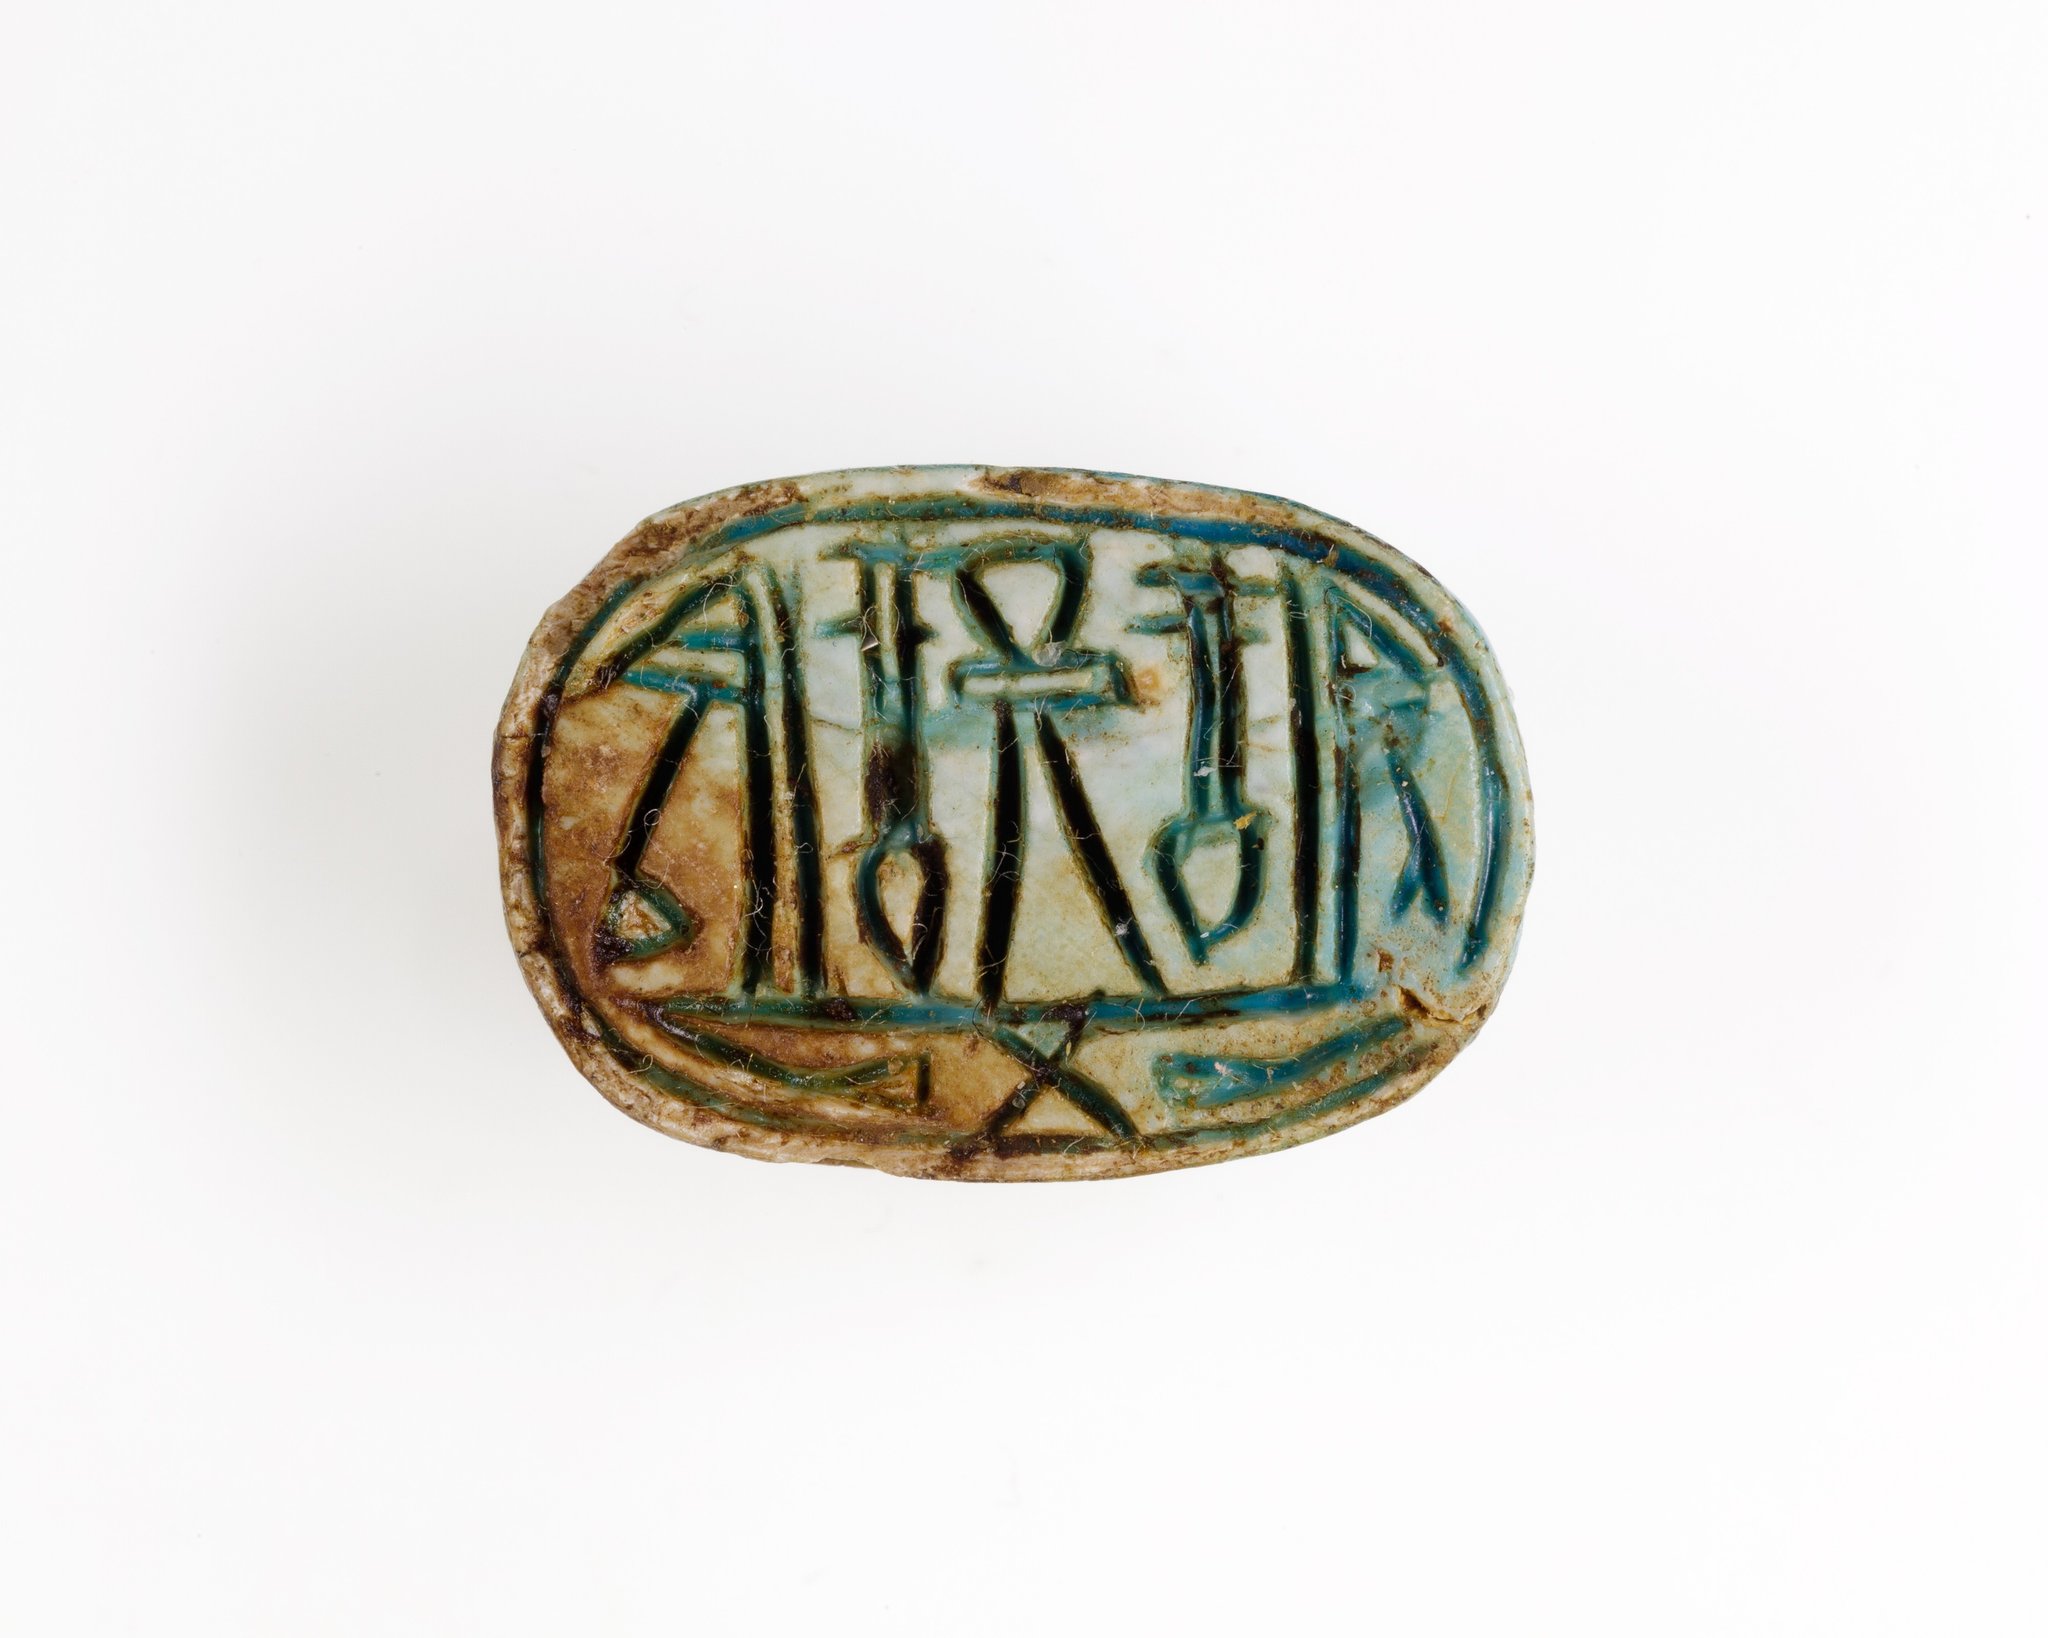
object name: scarab, papyrus, sa hieroglyph, nb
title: Scarab Incised with Hieroglyphs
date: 1850-1640 BCE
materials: stone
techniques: glazing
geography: egypt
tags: hieroglyphs,scarabs